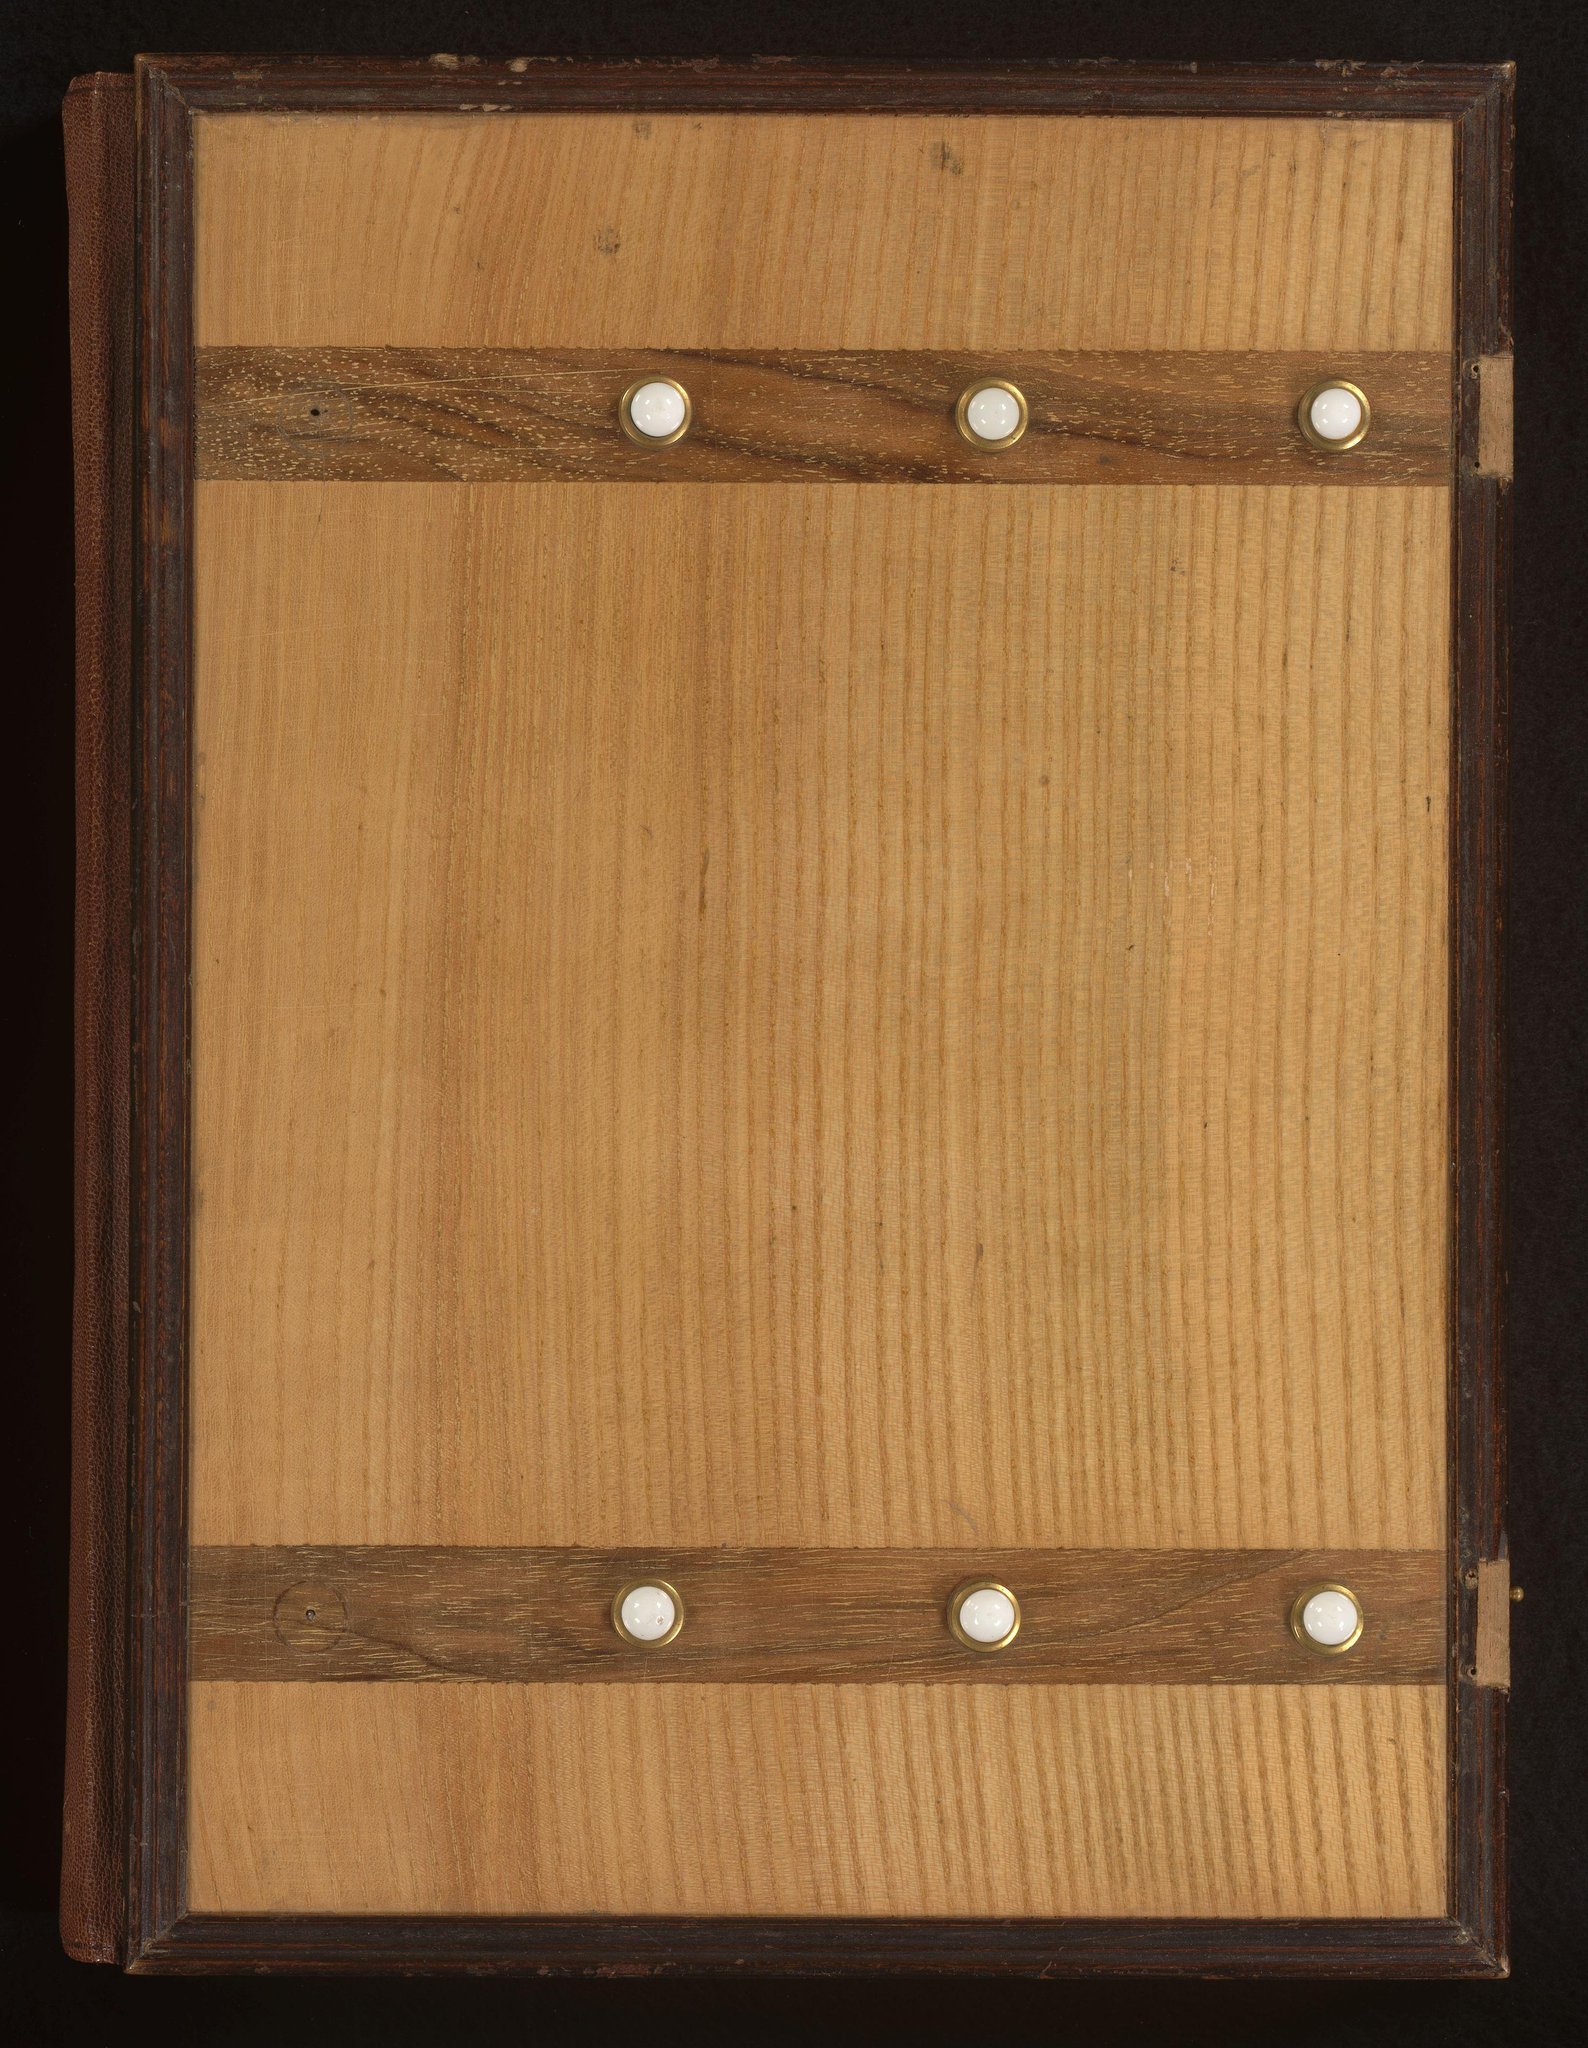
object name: slip in album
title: Fotoalbum met 32 foto's van bekende personen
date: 1855-1900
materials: cardboard, leather, paper, photographic support, porcelain, wood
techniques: albumen print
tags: vienna, louise marie van orléans (koningin van belgië), laeken, leopold i (koning der belgen), historical persons - bb - woman, boy (child between toddler and youth), hunter, historical persons, head-gear: hat, emperor, head-gear: cap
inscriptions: collector's mark: ‘Dienst Verspreide Rijkskollekties (...) A 692’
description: Fotoalbum met 32 carte-de-visites op 8 van de 26 pagina's. Het album bevat portretten, onder andere van Ferdinand I van Bulgarije, Louise Marie van Orléans en koning Leopold I van België. Verder zijn de geportretteerden veelal van onbekende personen. De foto's zijn onder andere vervaardigd door Ludwig Angerer, E. Godinez en F. Joubert. Een groot deel van de foto's is vervaardigd in Wenen, daarnaast zijn enkele foto's vervaardigd in Frankrijk, Engeland, Spanje en Brazilië.